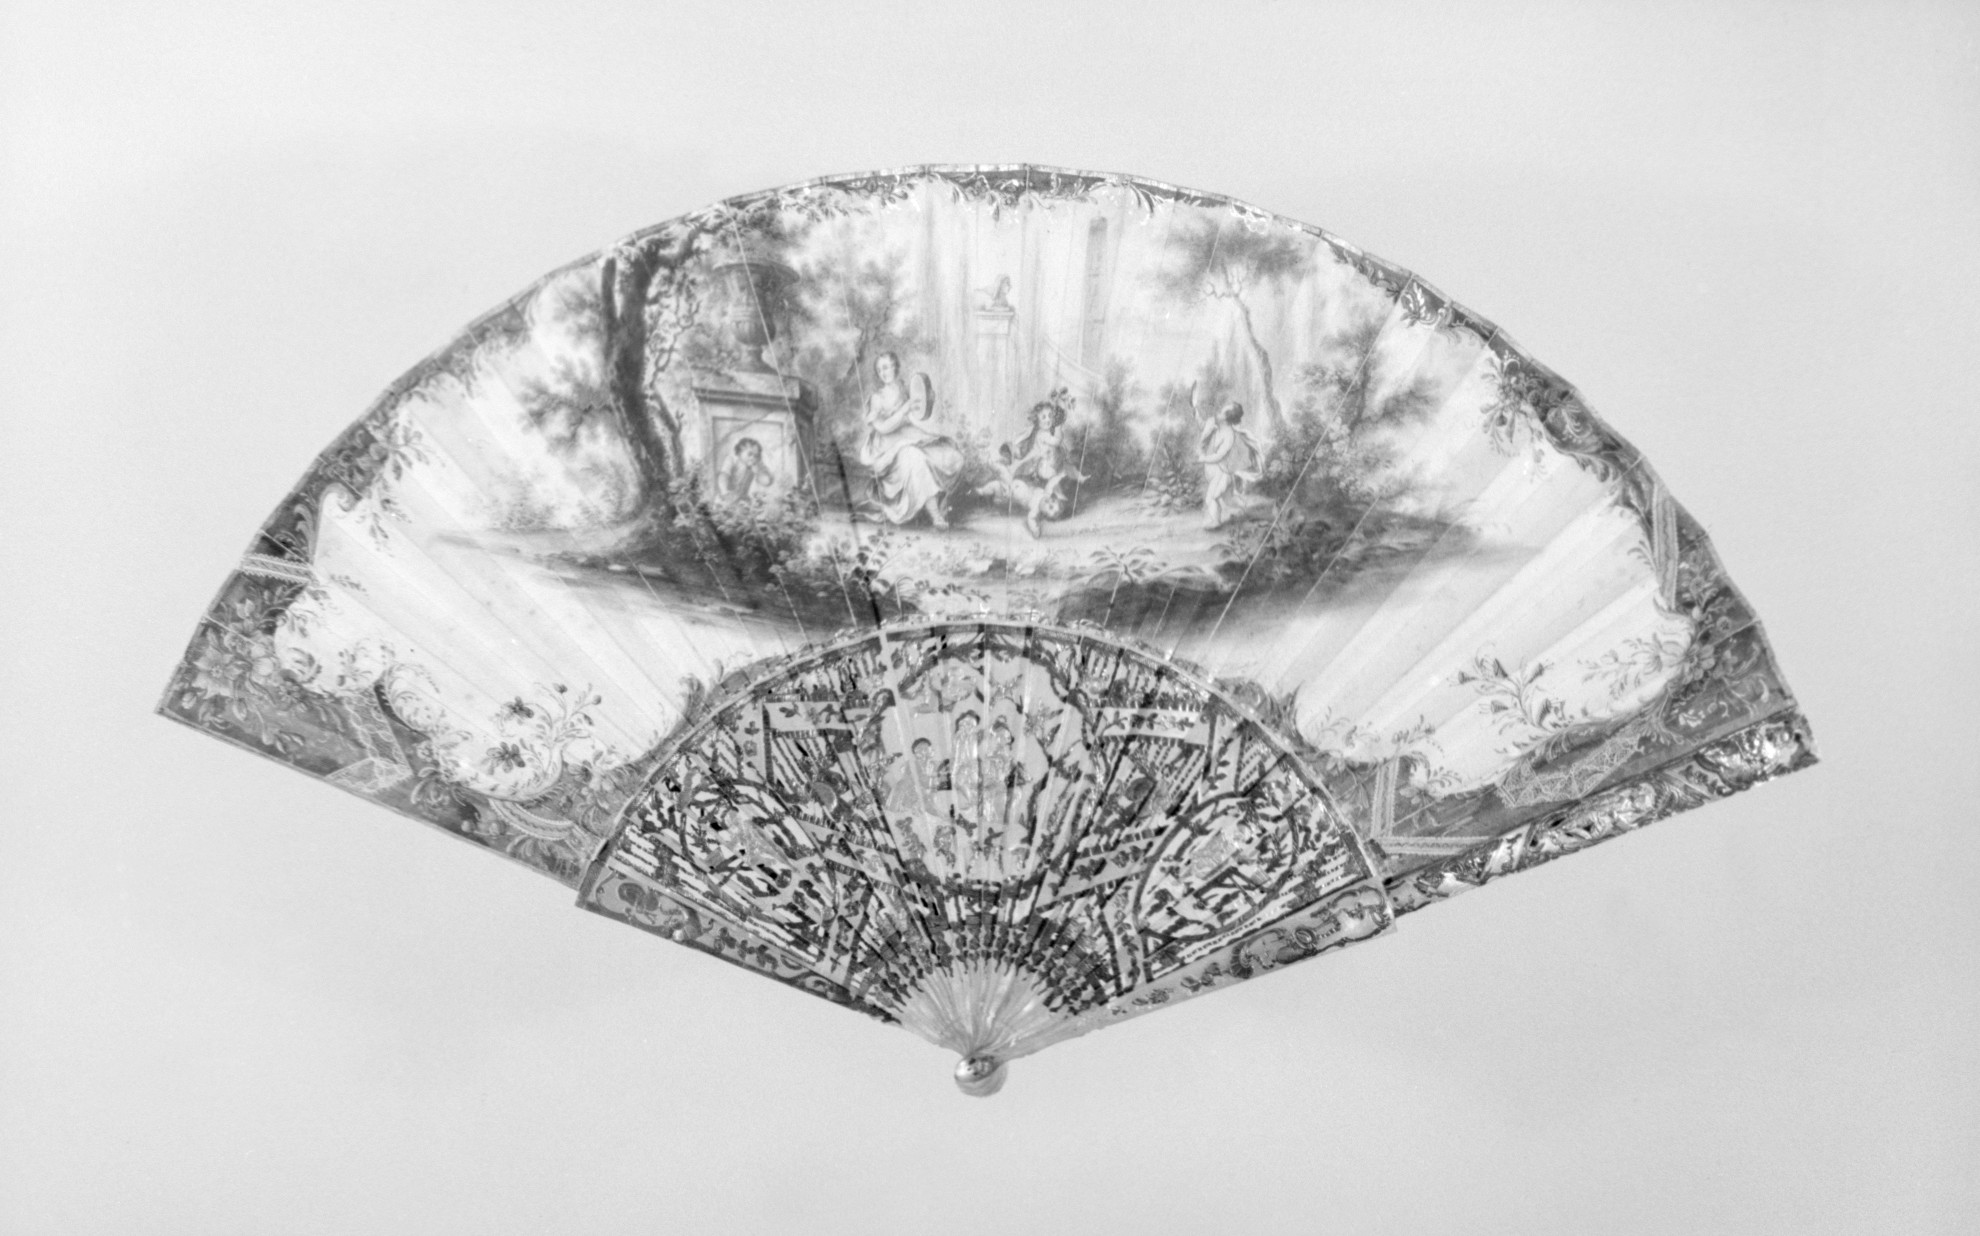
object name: fan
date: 1701-1800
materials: mother of pearl, paper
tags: women,putti